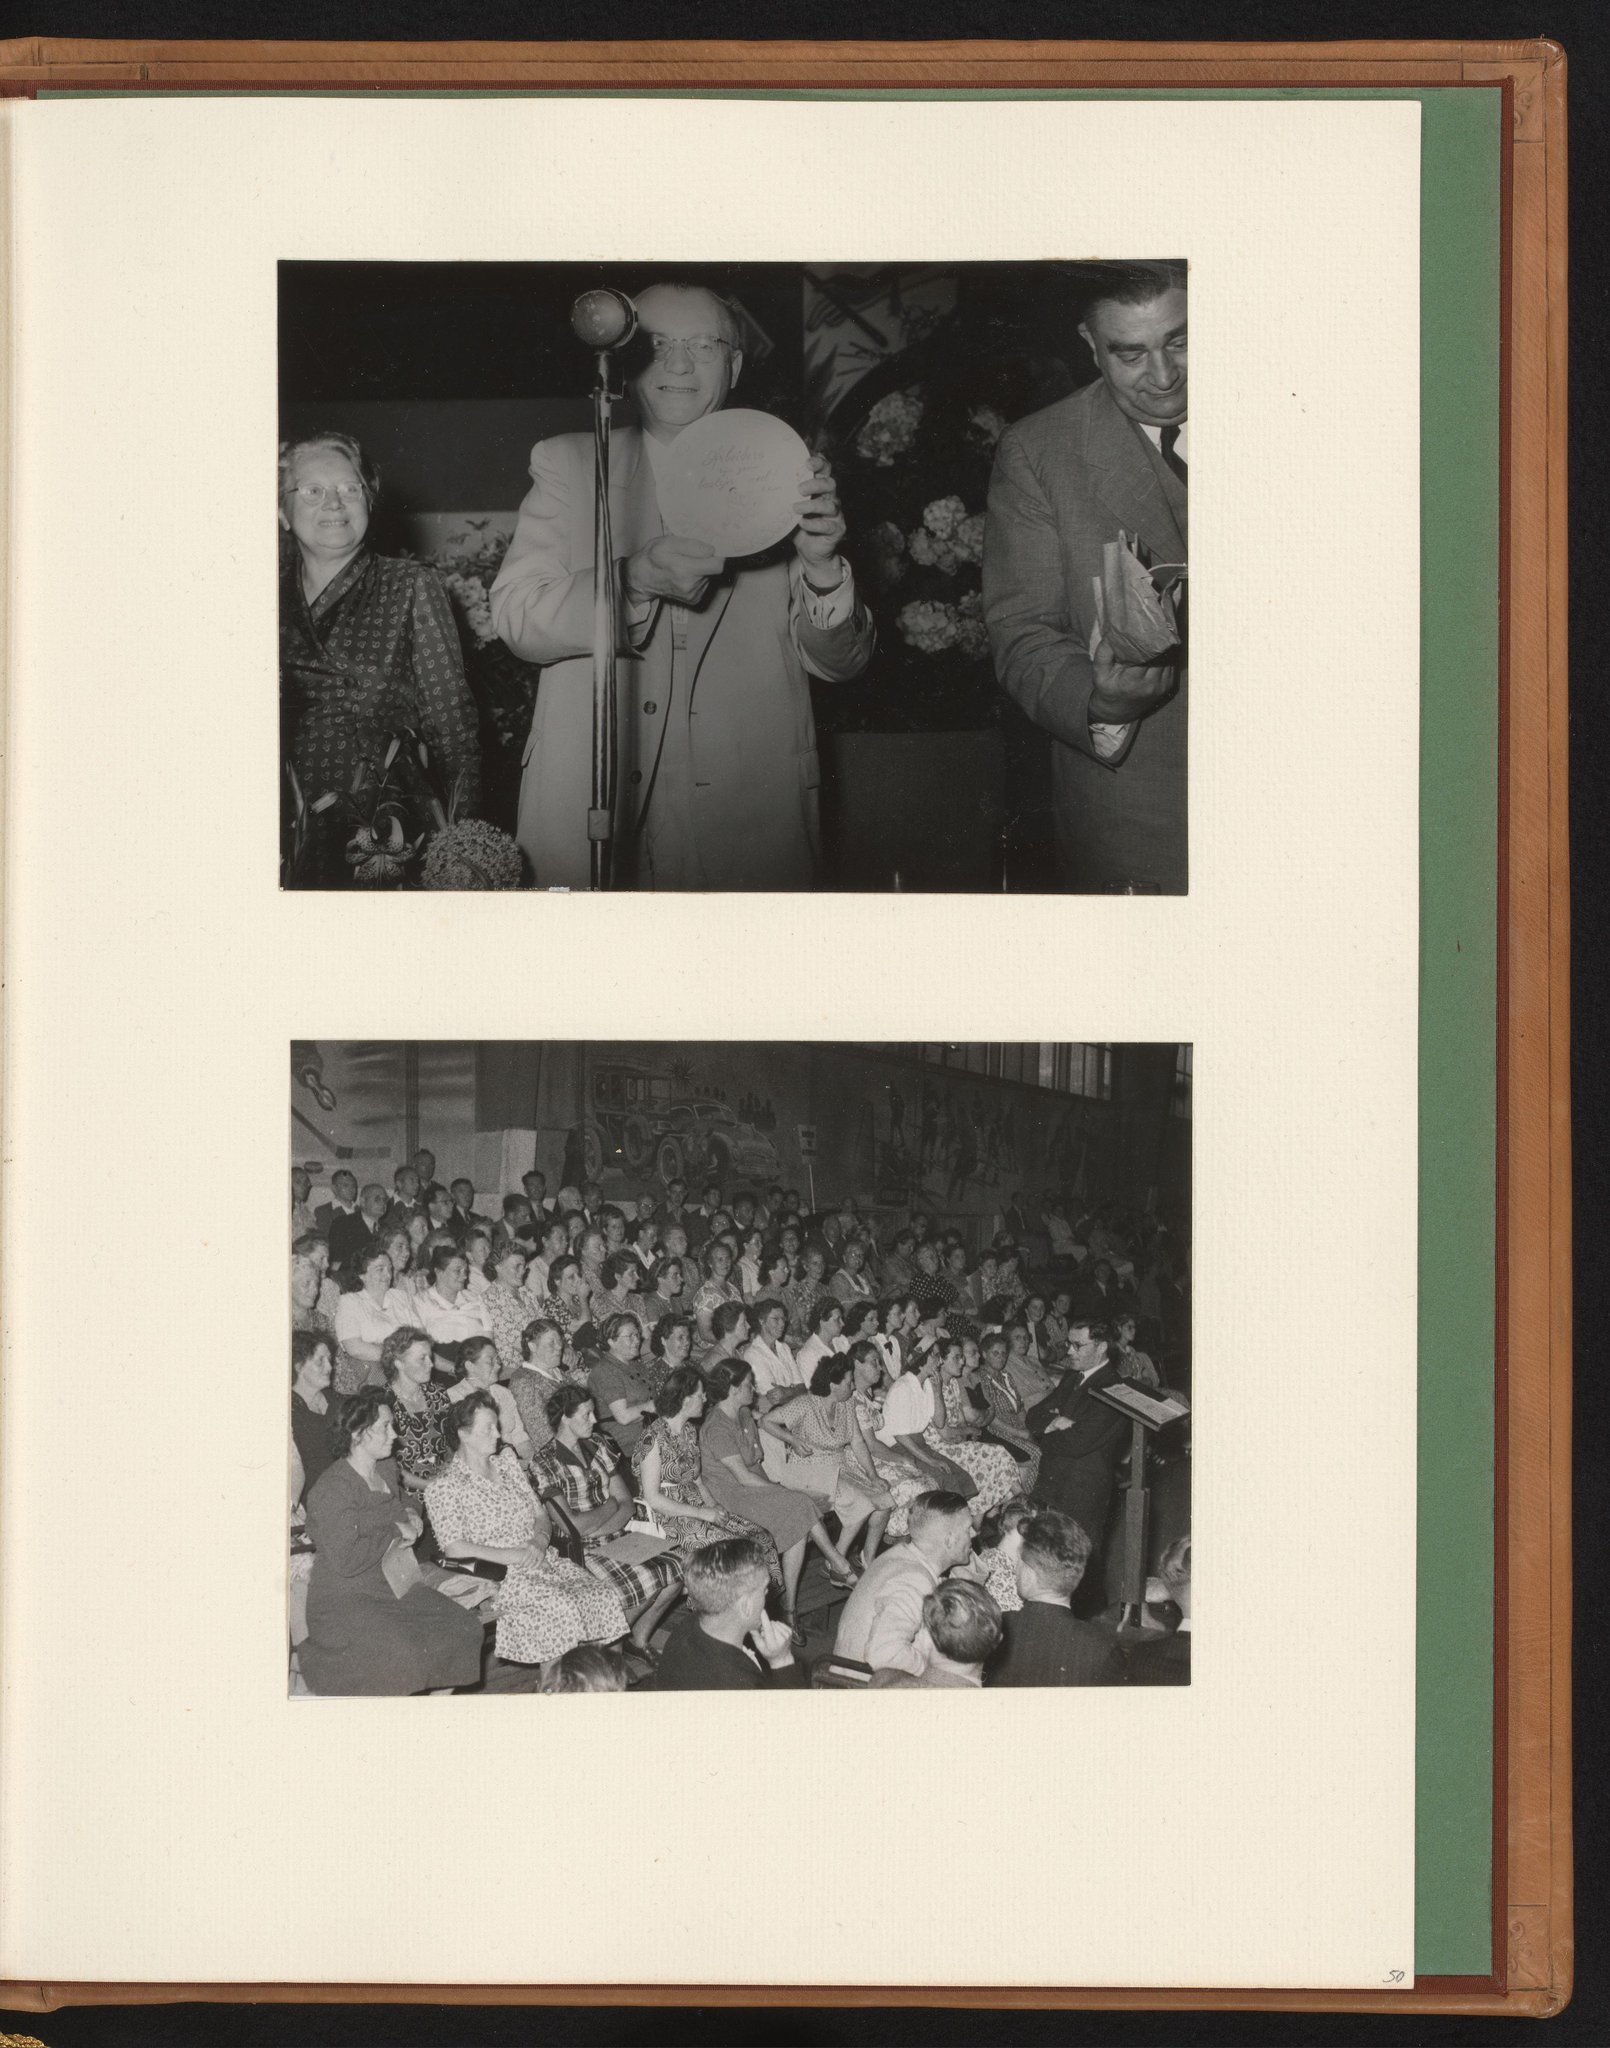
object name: photograph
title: Afscheid van Kupers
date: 1949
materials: paper, photographic support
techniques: gelatin silver print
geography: amsterdam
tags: gifts being accepted, modern professional organization, trade union, reception, cocktail party, amsterdam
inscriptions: company name: ‘Fotodienst Het Vrije Volk / Hekelveld 15, Amsterdam’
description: Blad met twee foto's waarin Kupers een bord als geschenk ontvangt (boven) en gezicht op het publiek in de zaal (onder). Onderdeel van het fotoalbum ter gelegenheid van het afscheid van Evert Kupers als voorzitter van de NVV op 14 juli 1949 in Amsterdam.